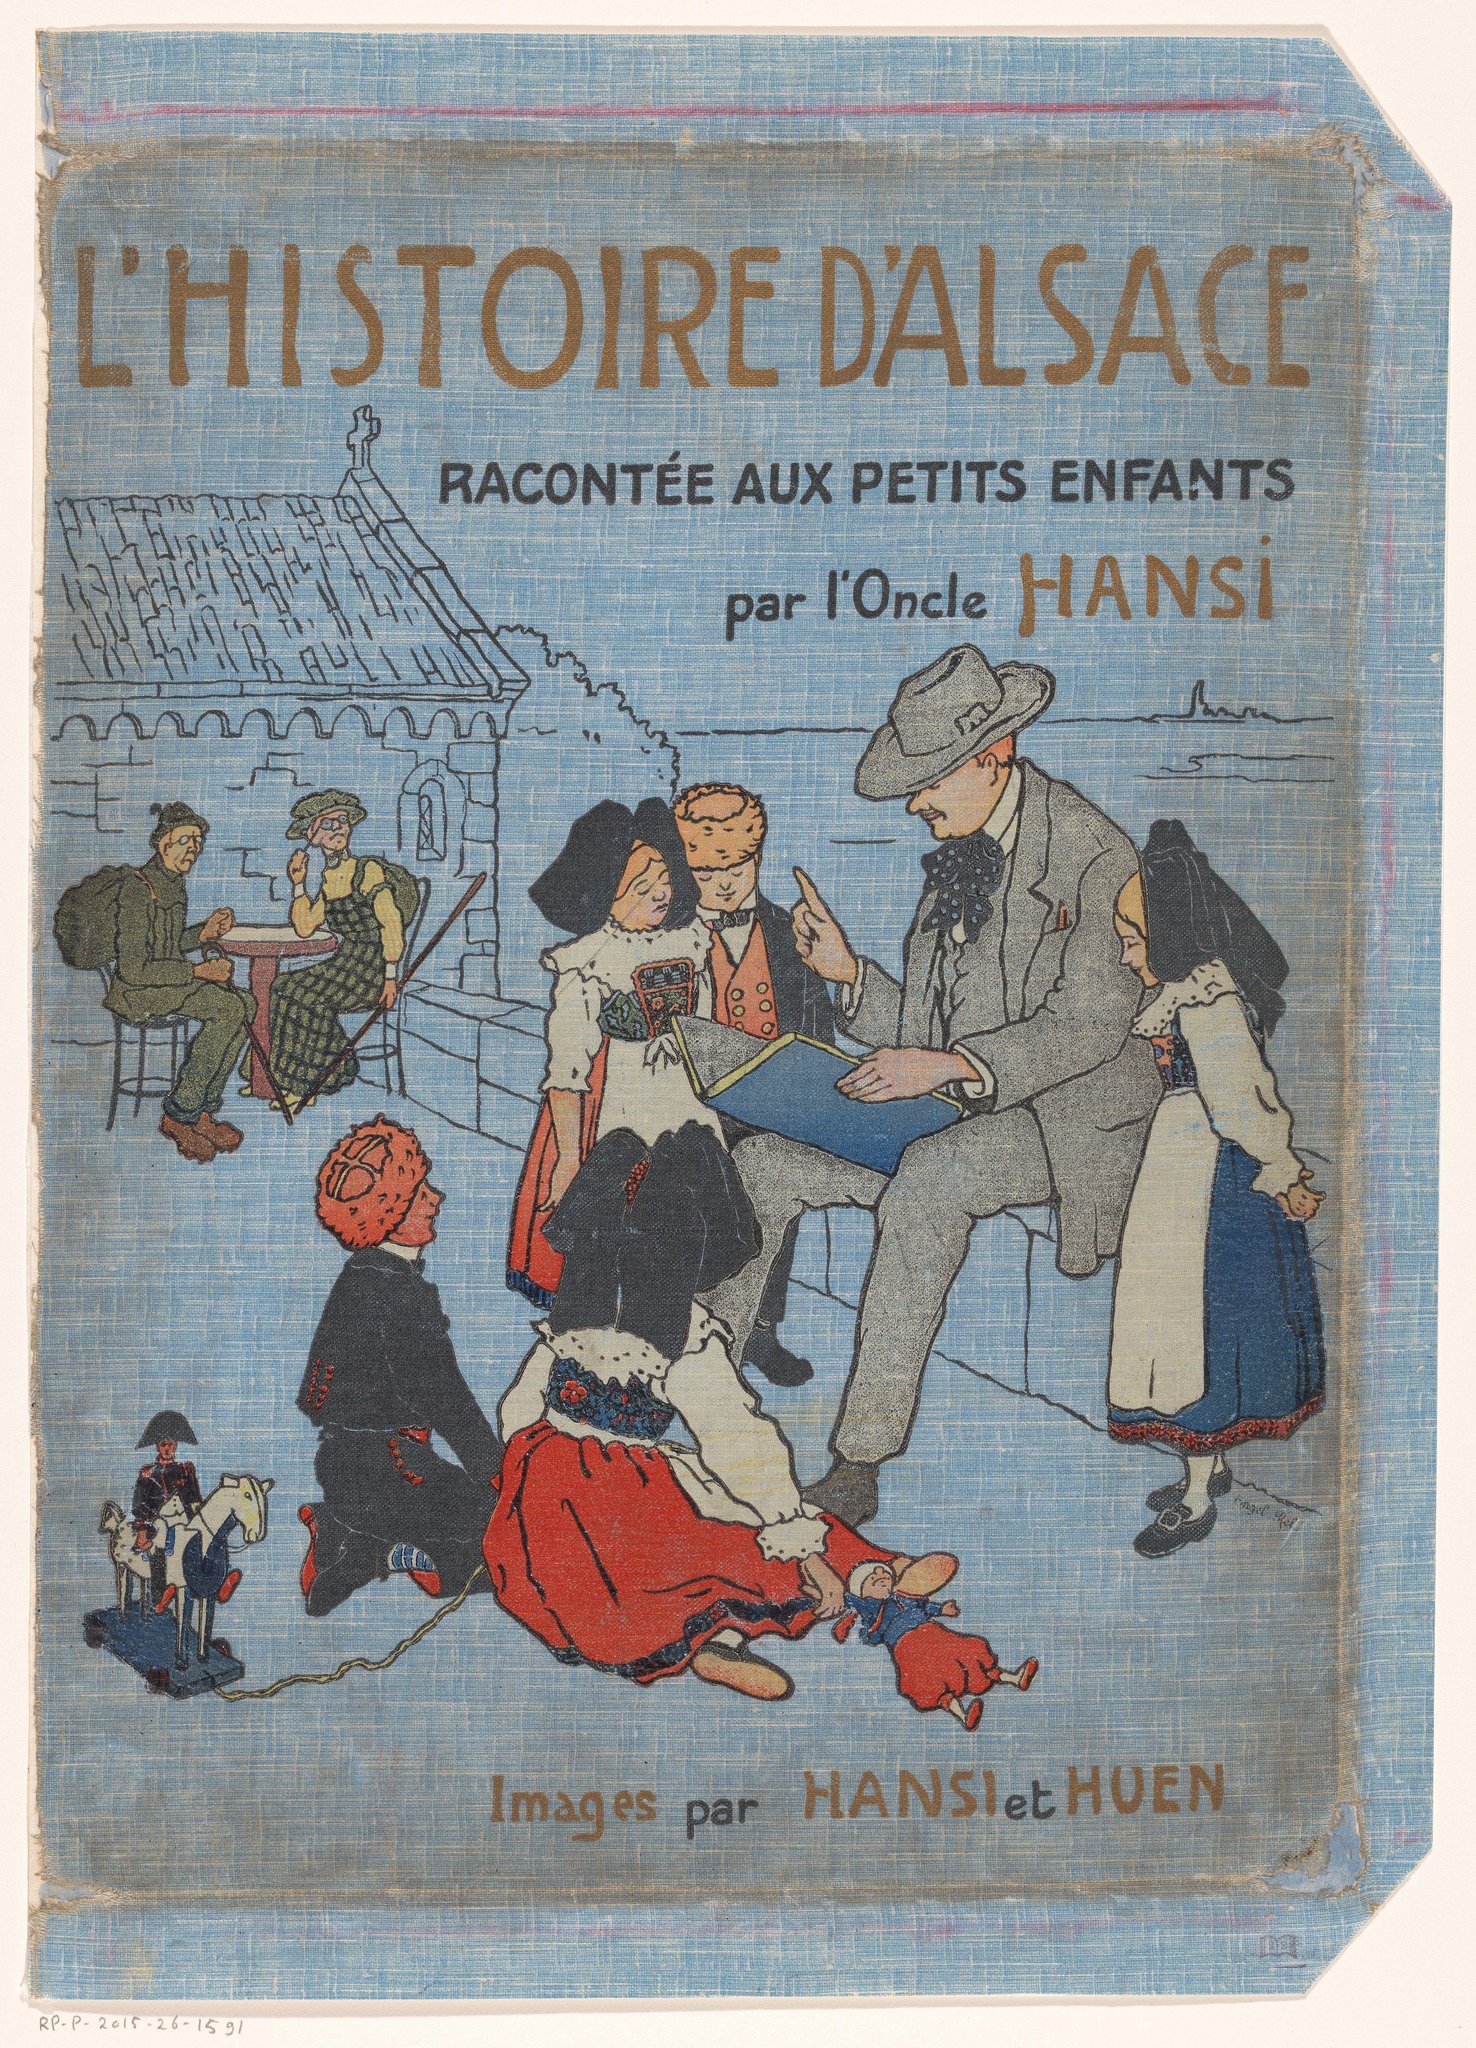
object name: wrapper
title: Oom Hansi leest kinderen voor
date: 1913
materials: linen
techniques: printing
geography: paris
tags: book, folk costume, regional costume, reading to somebody, (playing with) toys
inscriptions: collector's mark: Lugt 4780, collector's mark: Lugt 2228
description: Zittend op een muur, leest oom Hansi voor uit een boek. Om hem heen twee meisjes en twee jongens in klederdracht. Een van de meisjes heeft een pop en een van de jongens een houten speelgoedpaard met een Franse generaal. In de achtergrond zitten een man en een vrouw aan een tafel.